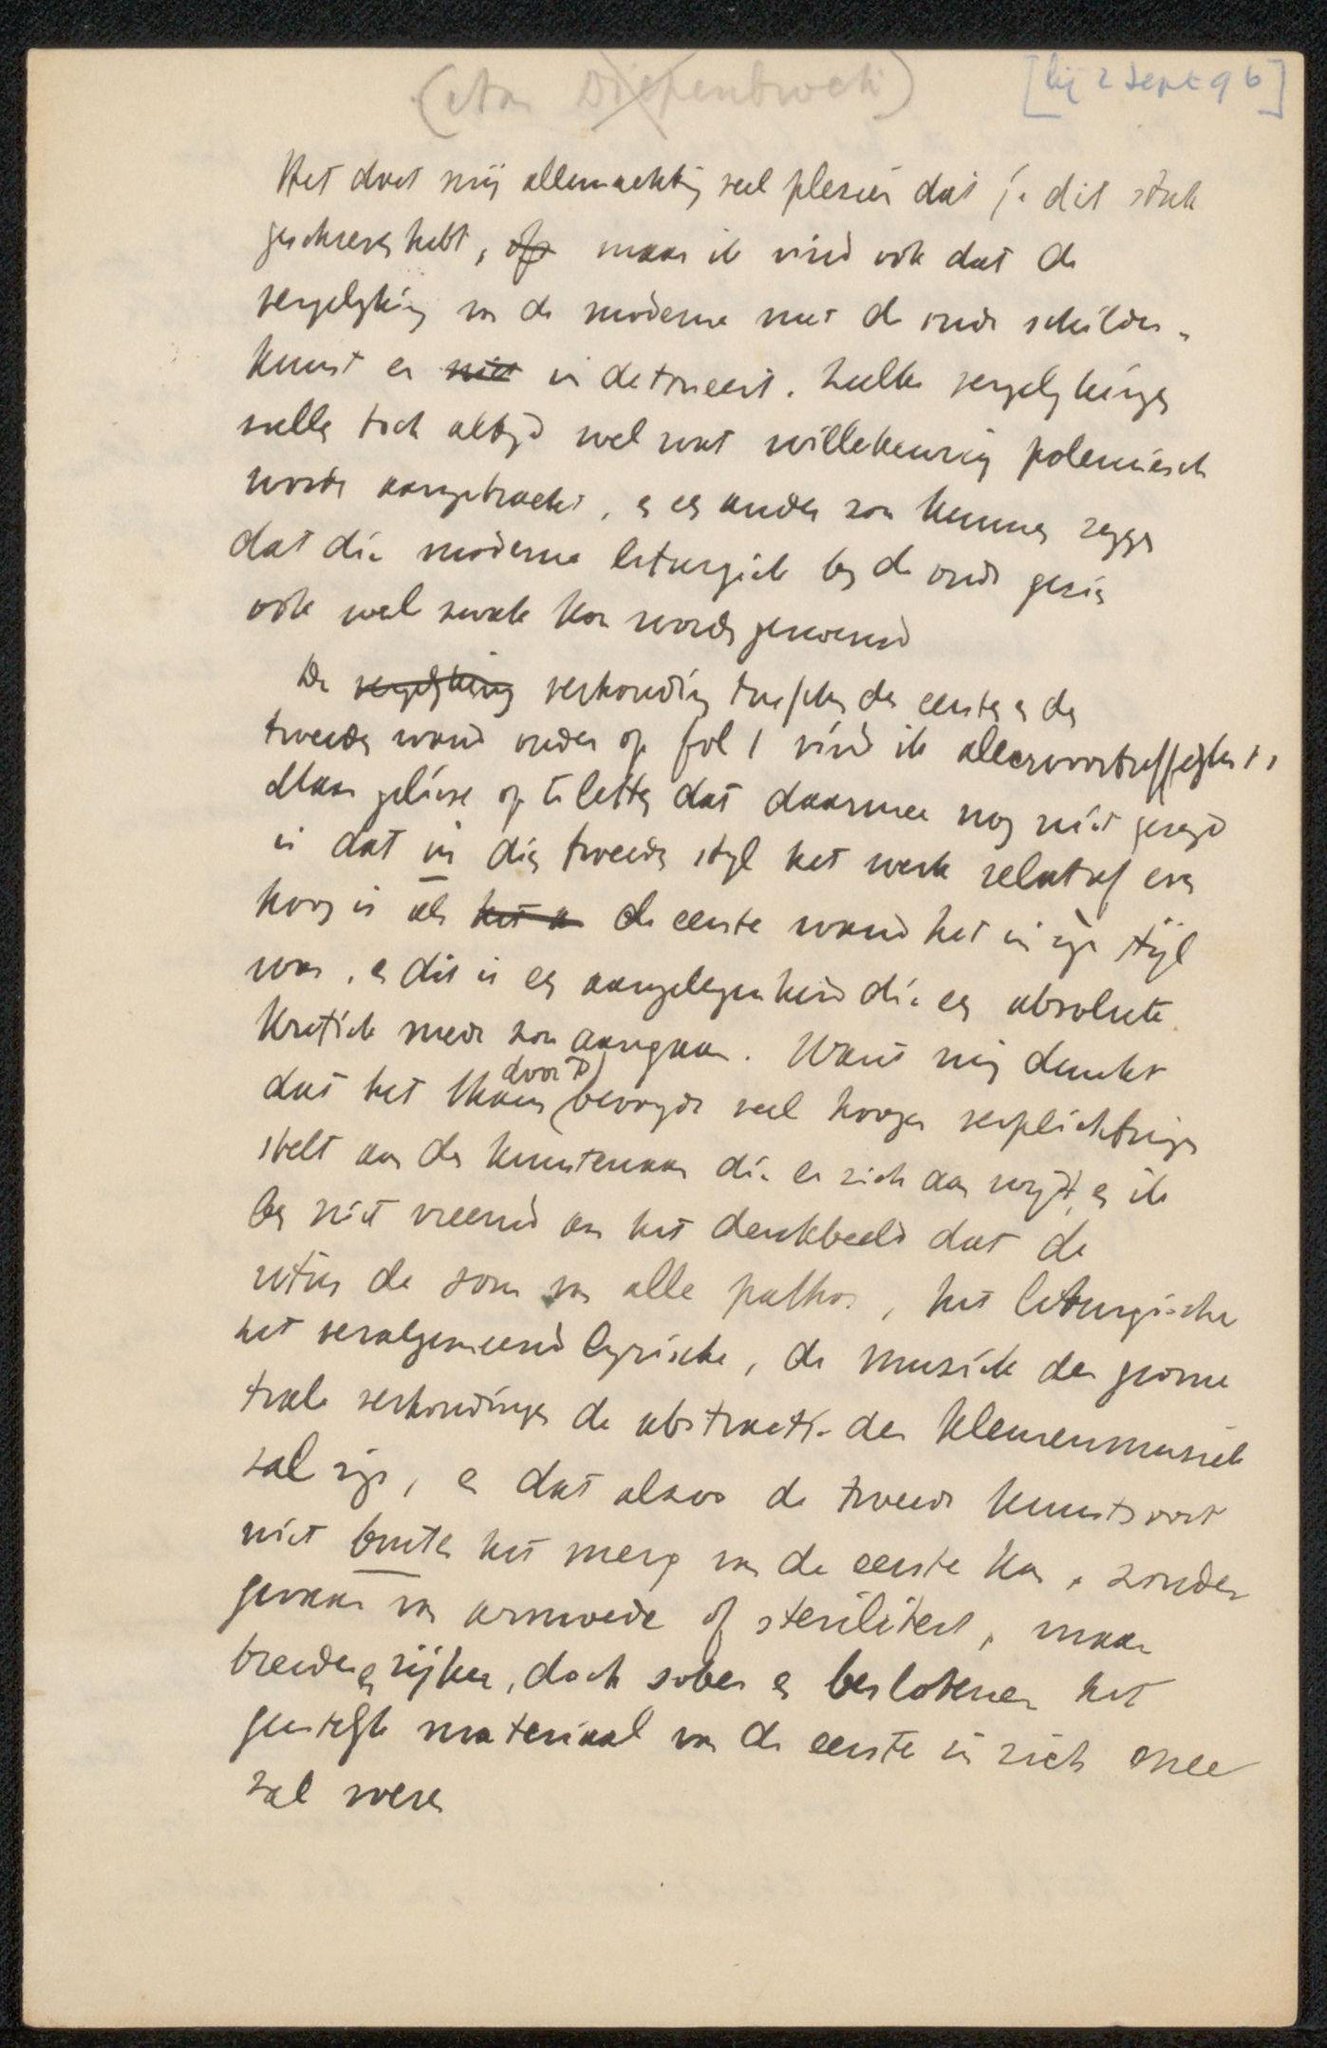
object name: letter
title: Brief aan Alphons Diepenbrock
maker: jan veth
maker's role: designer, draughtsman, painter, print maker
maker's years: 1864-1925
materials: ink, paper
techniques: pen, writing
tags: den bosch, amsterdam, painter, print maker, draughtsman, antoon derkinderen, alphons diepenbrock, applied arts, arts and crafts; industrial design, printed matter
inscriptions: watermark, collector's mark: ‘RPK’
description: Brief betreft kladversie van brief RP-D-1984-40-J.P.VETH-112.